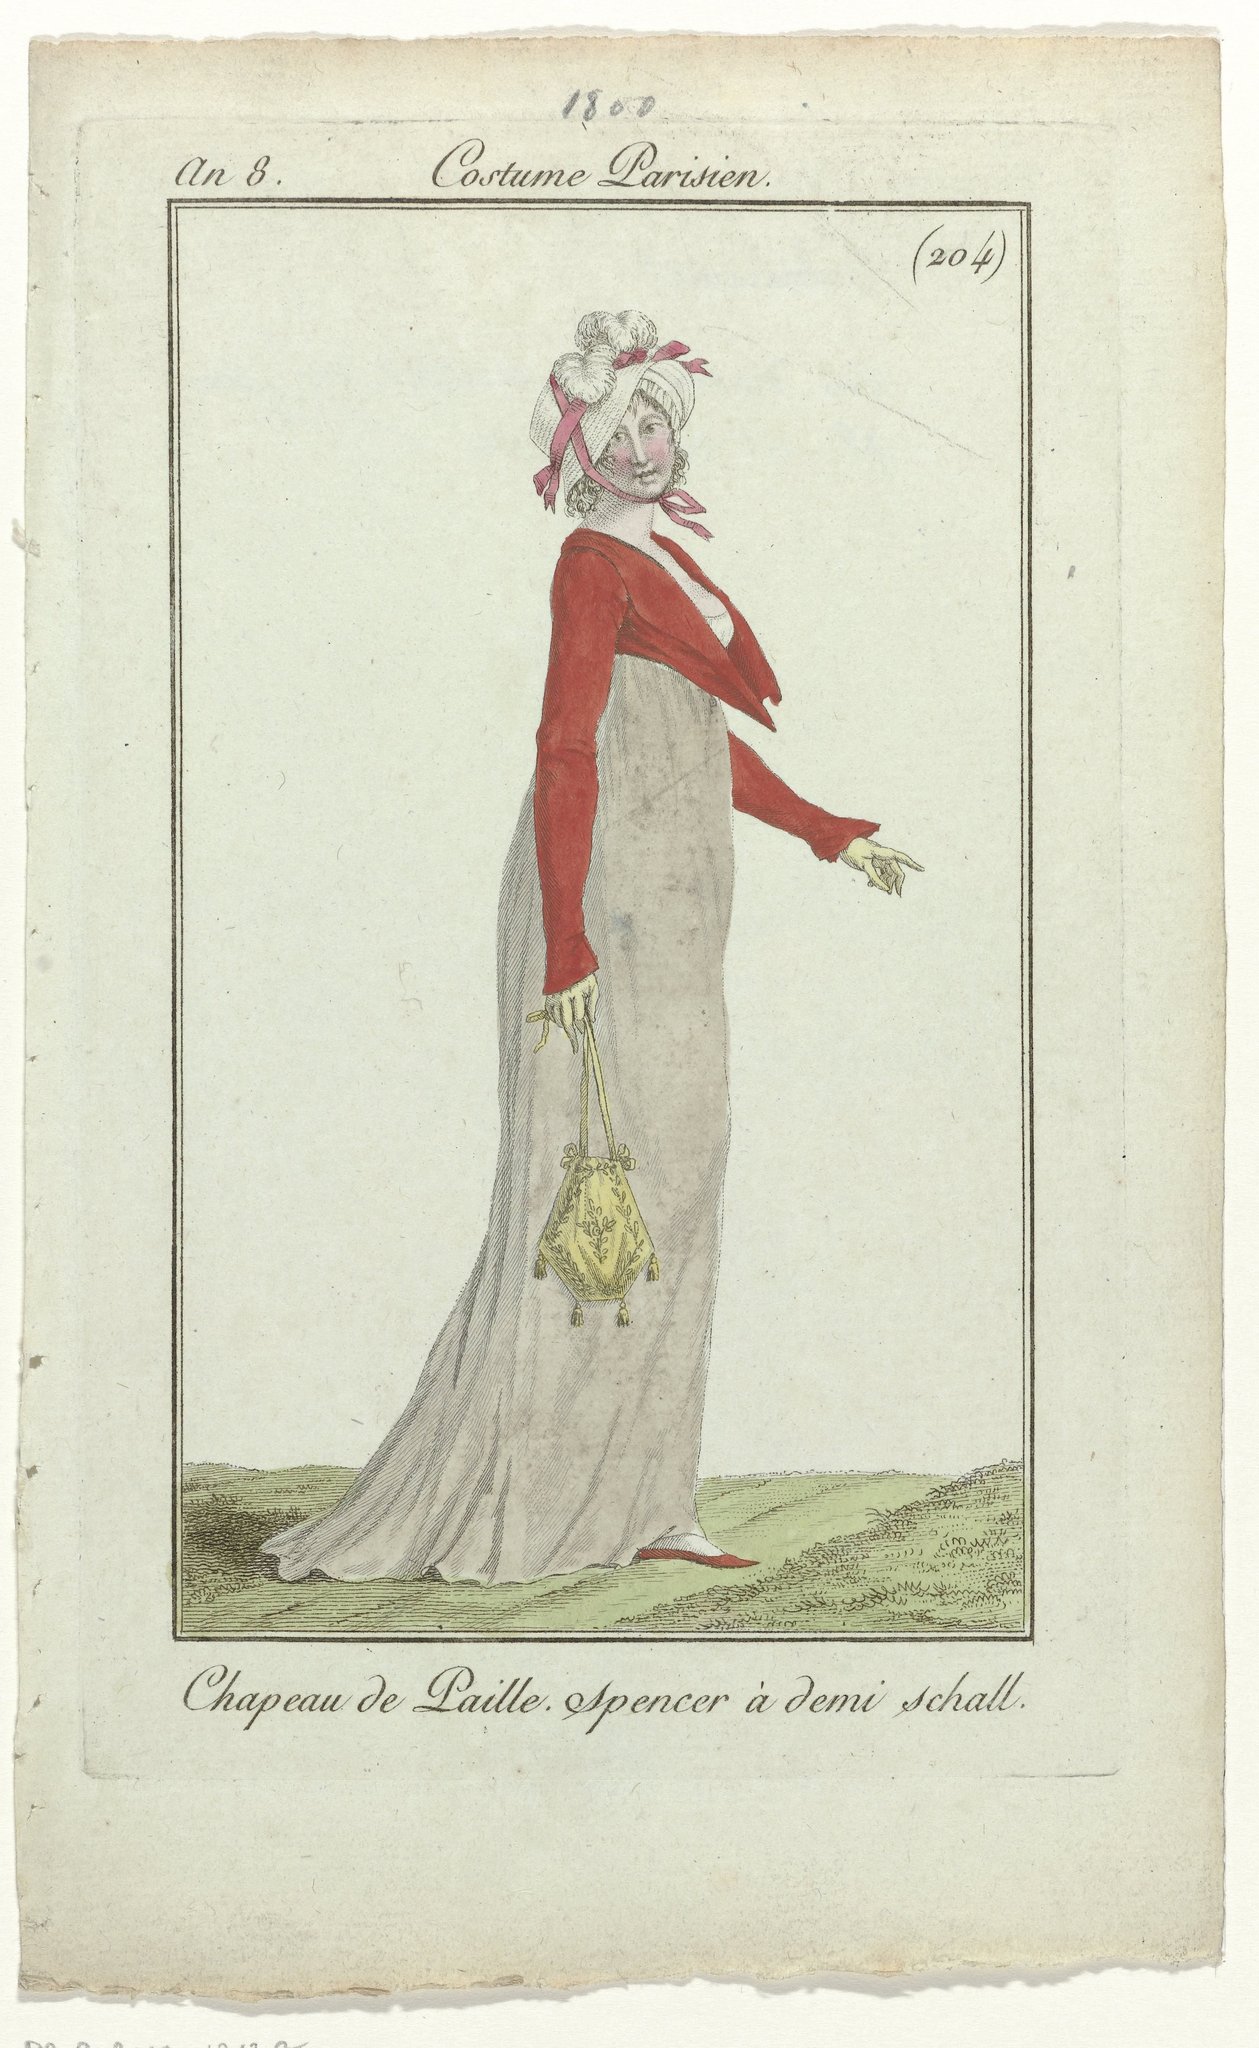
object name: fashion print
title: Journal des Dames et des Modes, Costume Parisien, 31 mars 1800, An 8 (204) : Chapeau de Paill (...)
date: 1800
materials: paper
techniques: engraving, hand coloring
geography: paris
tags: bag (reticule) (+ women's clothes), clothing for the upper part of the body (spencer) (+ women's clothes), head-gear (straw hat) (+ women's clothes), fashion plates, shoes, sandals (+ women's clothes), gloves, mittens, etc. (+ women's clothes), dress, gown (+ women's clothes)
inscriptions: title: ‘Costume Parisien.’, caption: ‘Chapeau de Paille. Spencer à demi schall.’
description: Strohoed versierd met linten en struisveren. 'Spenser à demi schall' op een japon met sleep. Verdere accessoires: handschoenen, reticule met borduurwerk en kwastjes, platte schoen met puntige neus. De prent maakt deel uit van het modetijdschrift Journal des Dames et des Modes, uitgegeven door Pierre de la Mésangère, Parijs, 1797-1839.